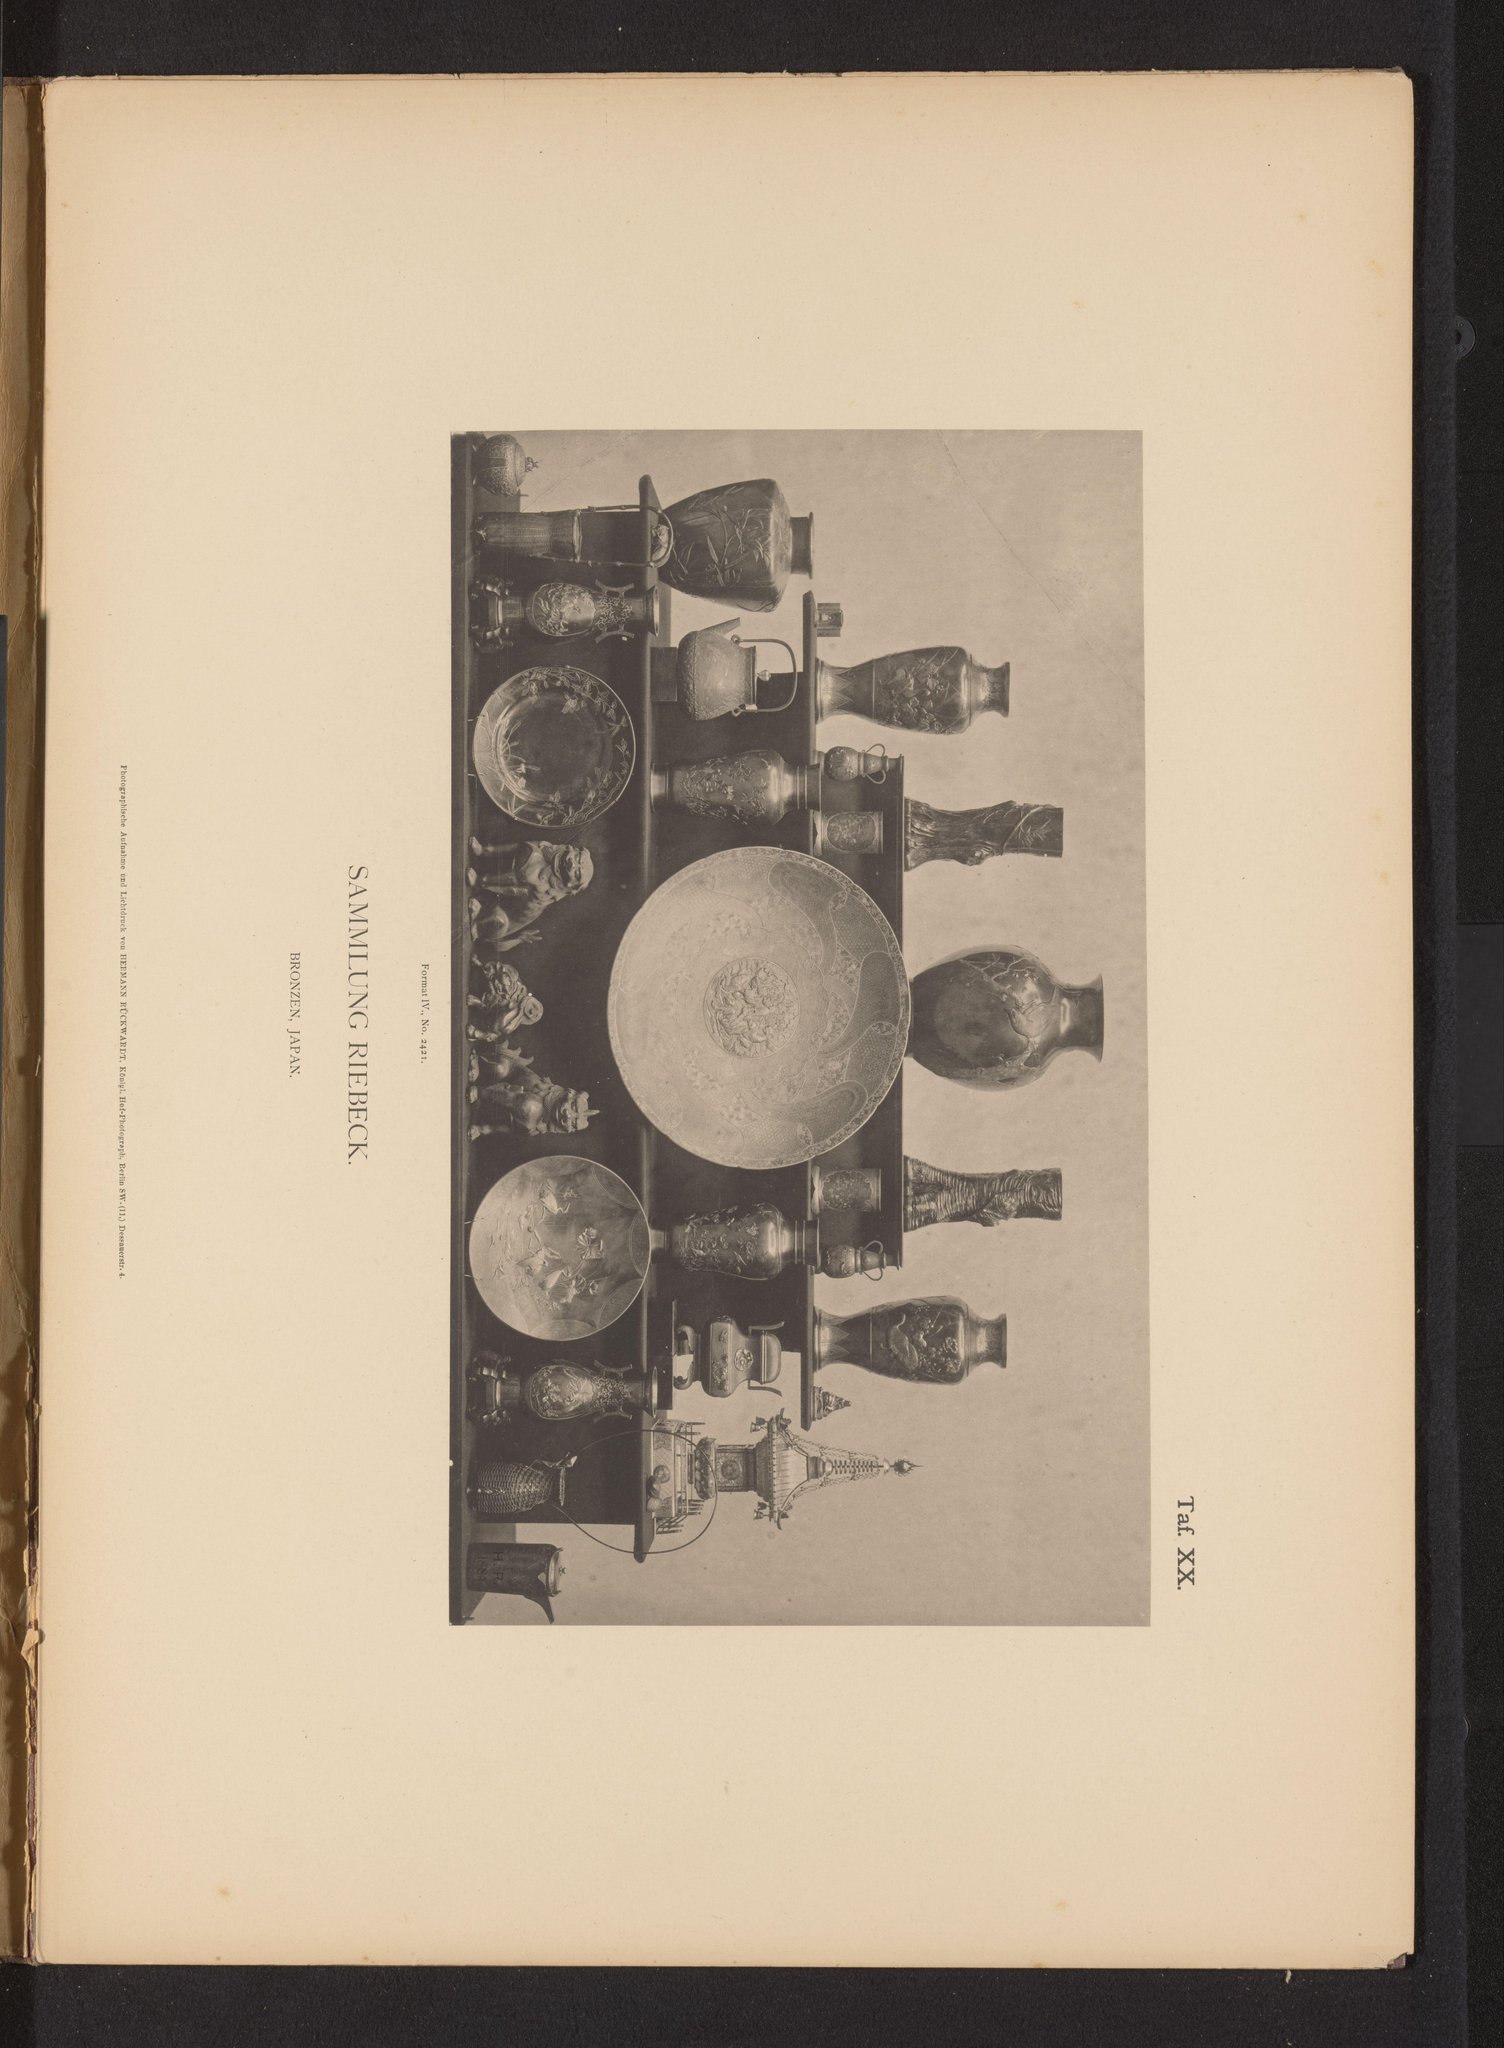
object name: photomechanical print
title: Bronzen objecten uit Japan uit de verzameling van Emil Riebeck, op de binnenplaats van het Kunstgewerbemuseum in Berlijn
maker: hermann rückwardt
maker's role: fotograaf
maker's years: 1845-1919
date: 1884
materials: paper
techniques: photograph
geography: berlin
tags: permanent exhibition, museum, dish, plate, saucer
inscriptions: number: ‘Taf. XX.’, address: ‘Photographische Aufnahme und Lichtdruck von HERMANN RÜCKWARDT, Königl. Hof-Photograph, Berlin SW.(11,) Dessauerstr. 4.’, number: ‘Format IV., No. 2421.’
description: Deze prent maakt deel uit van een omslag met 21 prenten en 1 tekstblad.